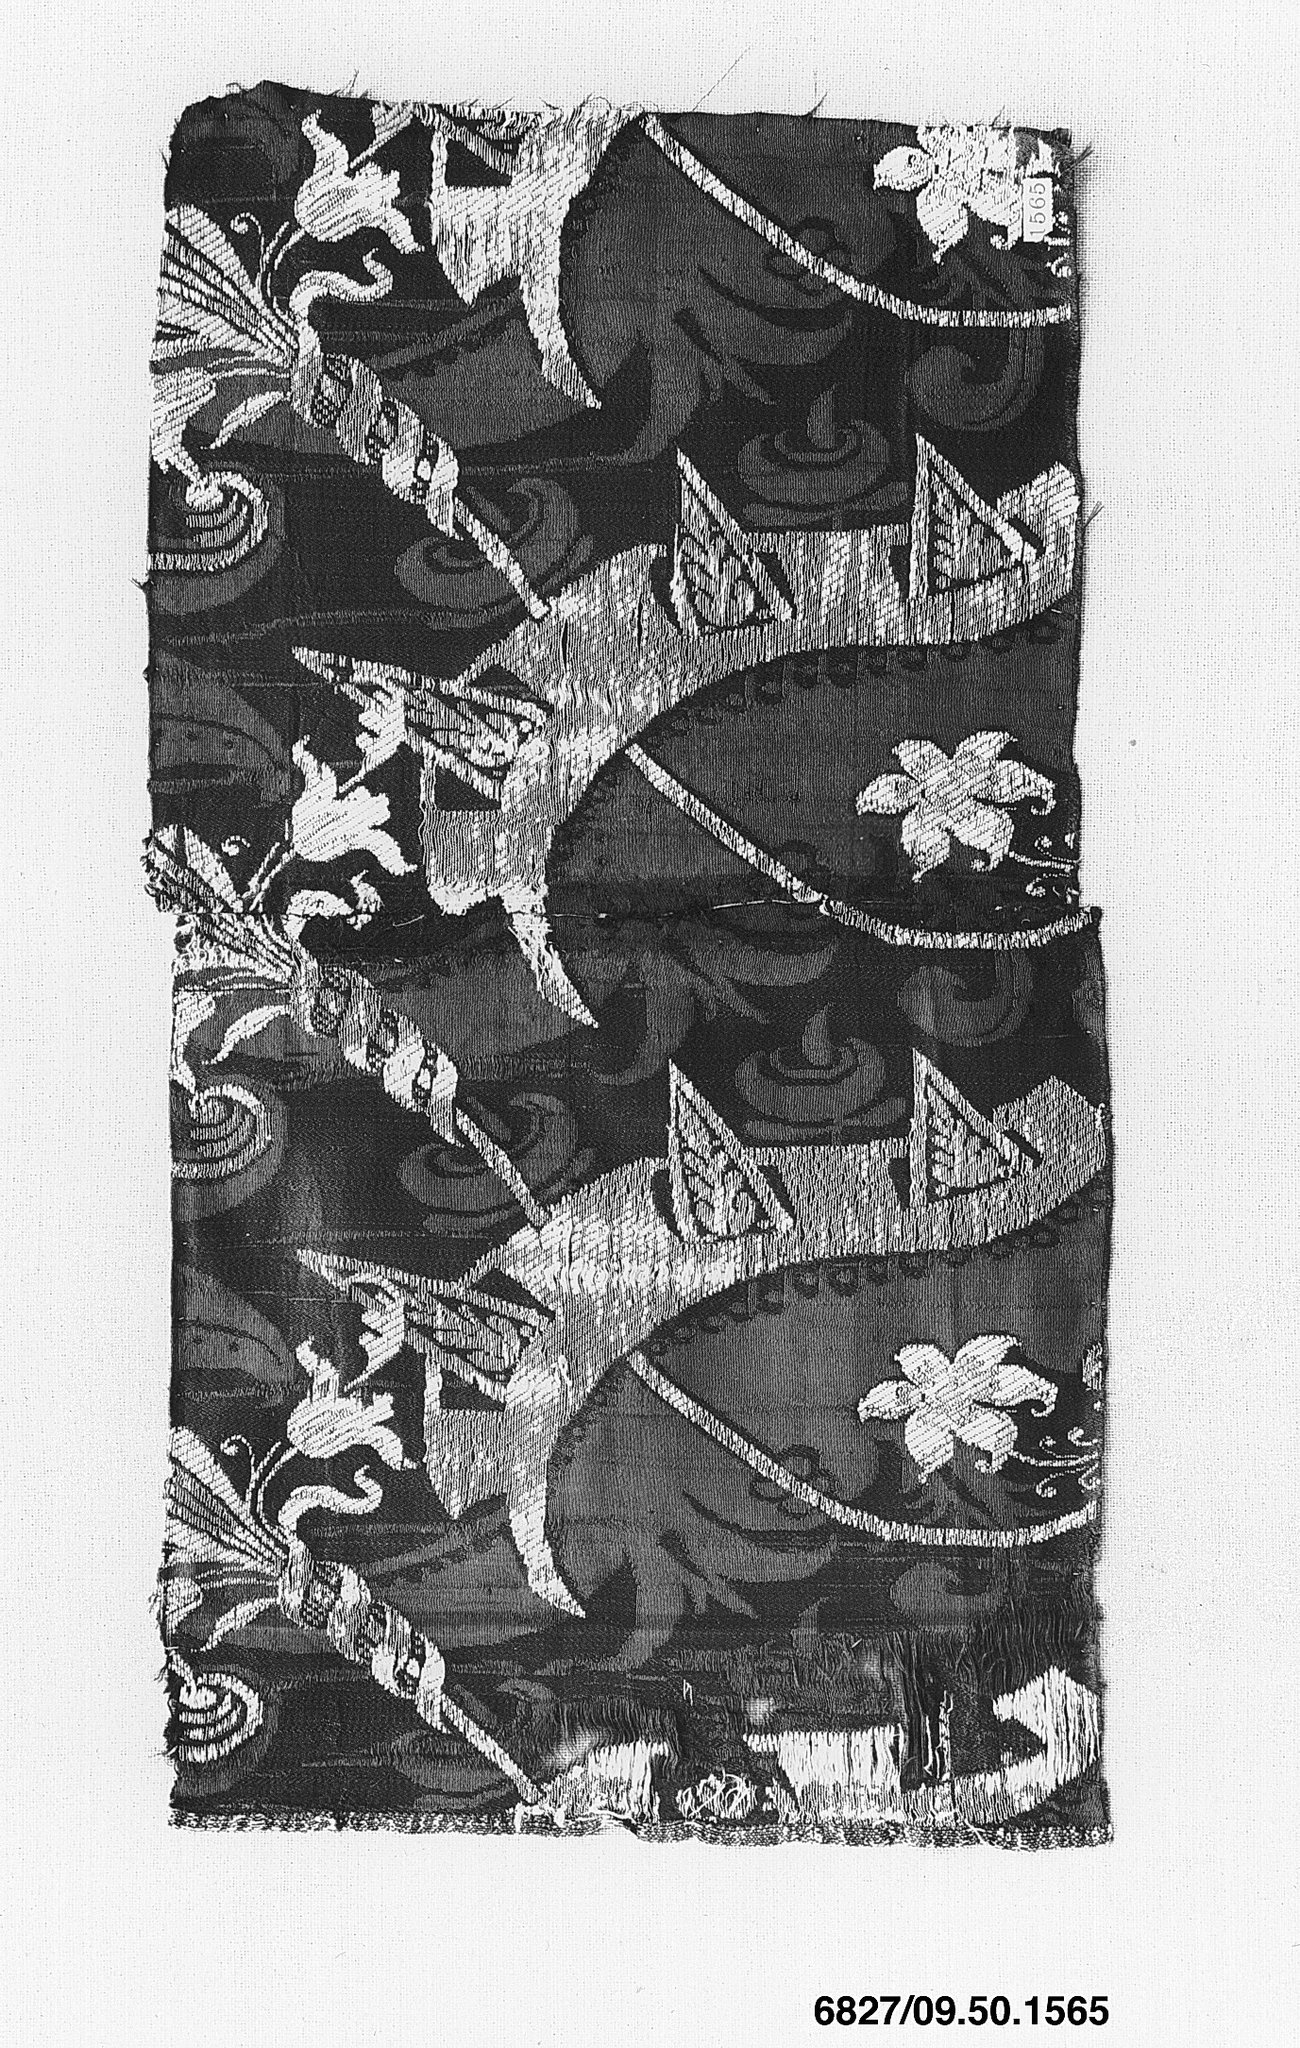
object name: piece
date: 1601-1800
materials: metal thread, silk